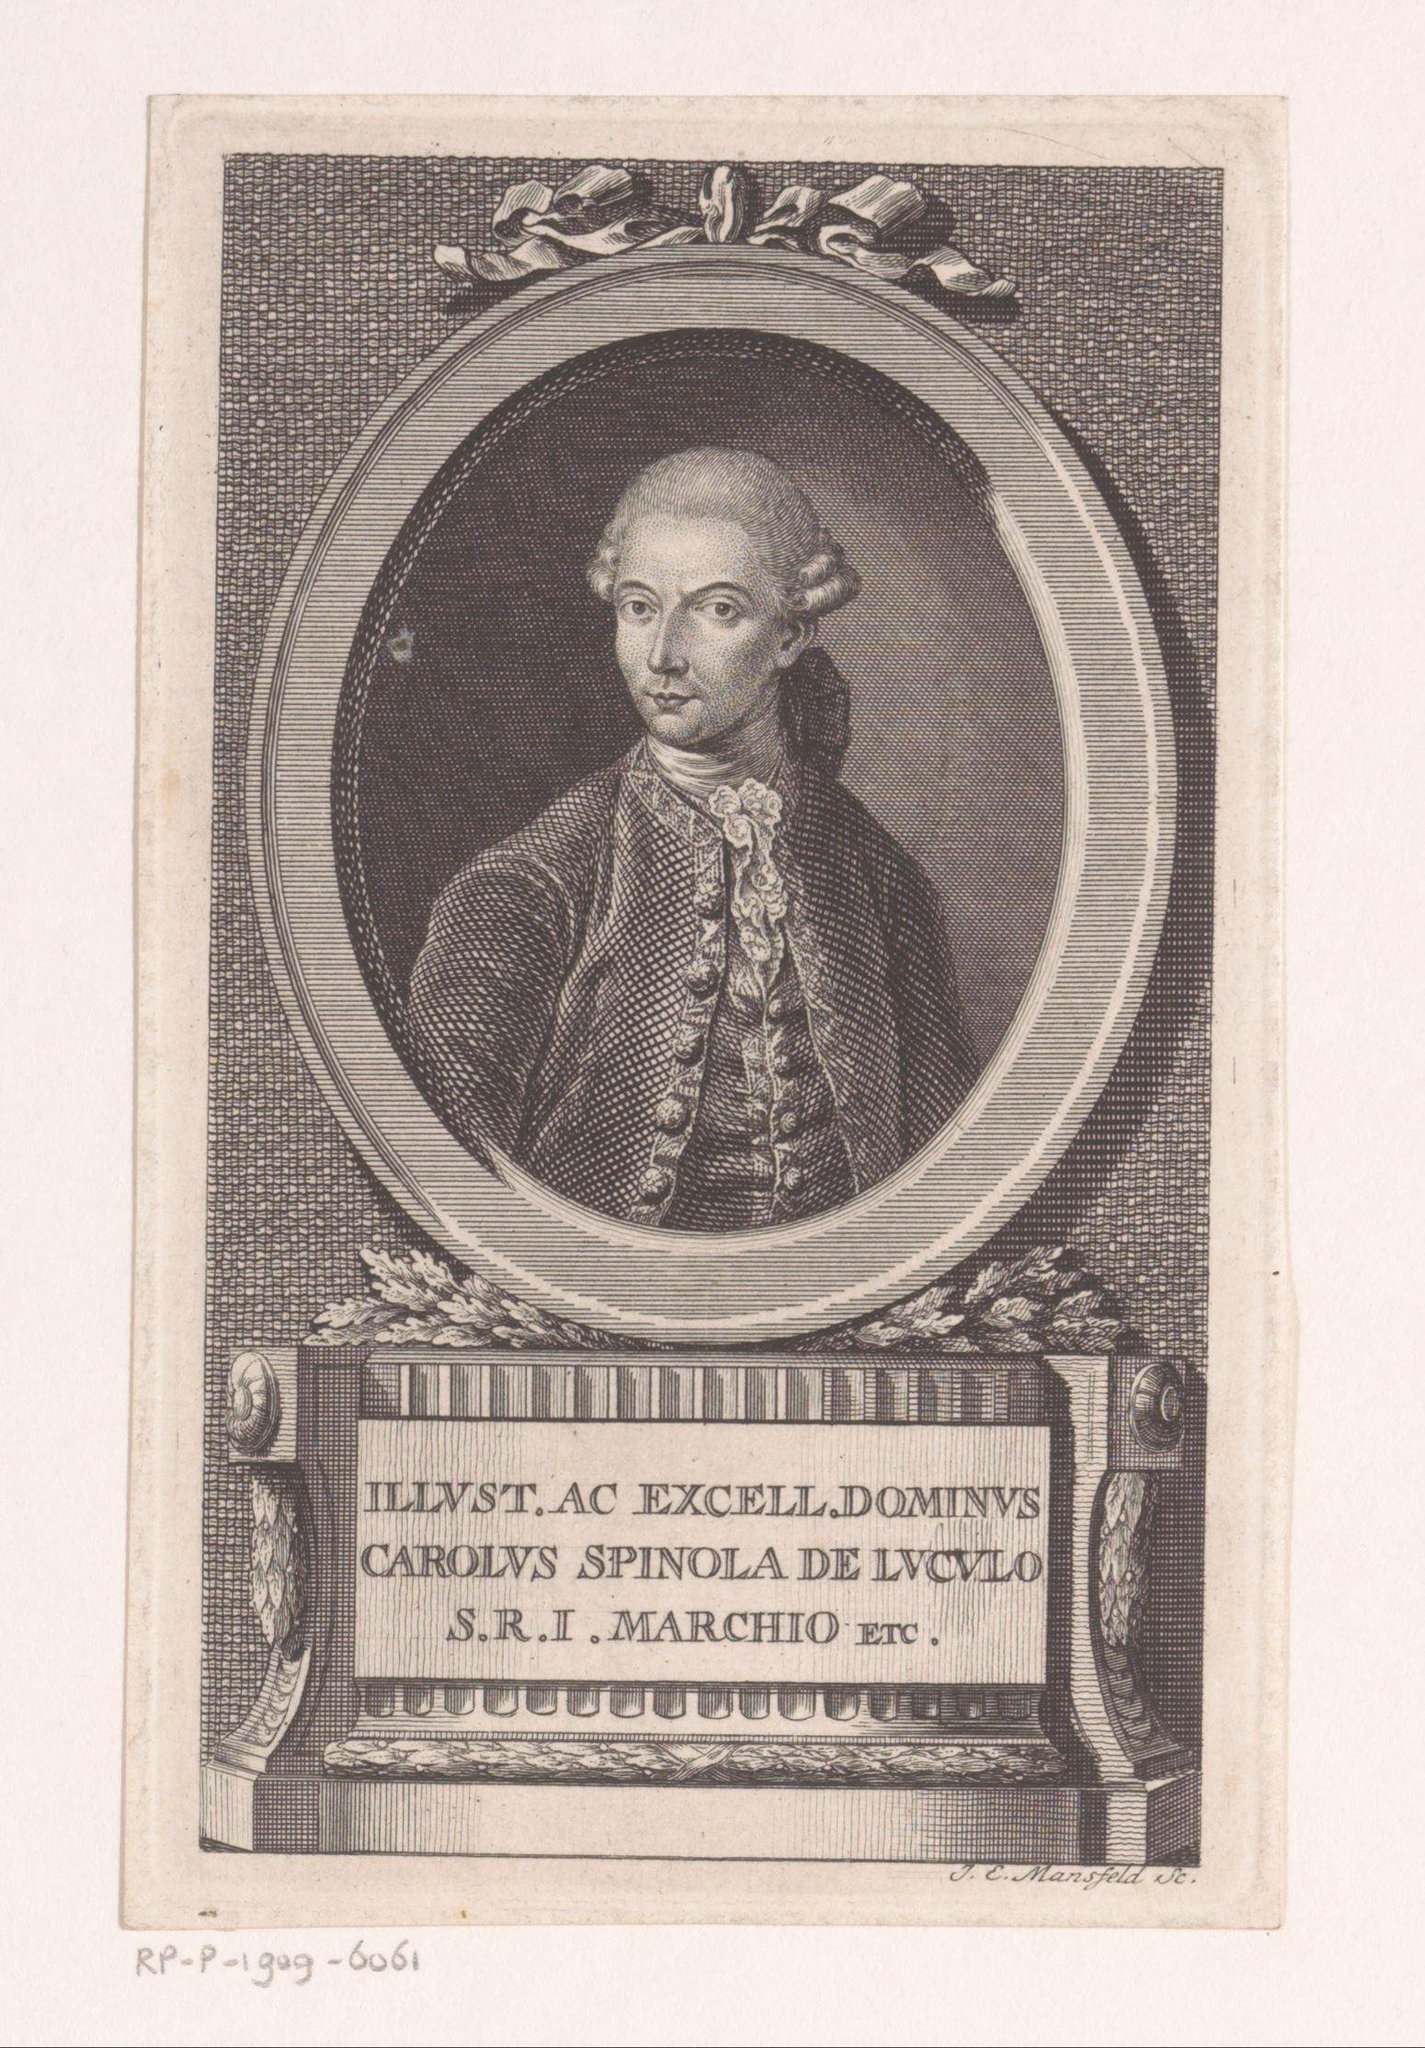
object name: print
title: Portret van Carlo Spinola di Luculo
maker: johann ernst mansfeld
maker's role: print maker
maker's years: 1739-1796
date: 1749-1796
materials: paper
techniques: engraving, etching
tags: historical persons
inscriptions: collector's mark: Lugt 2228